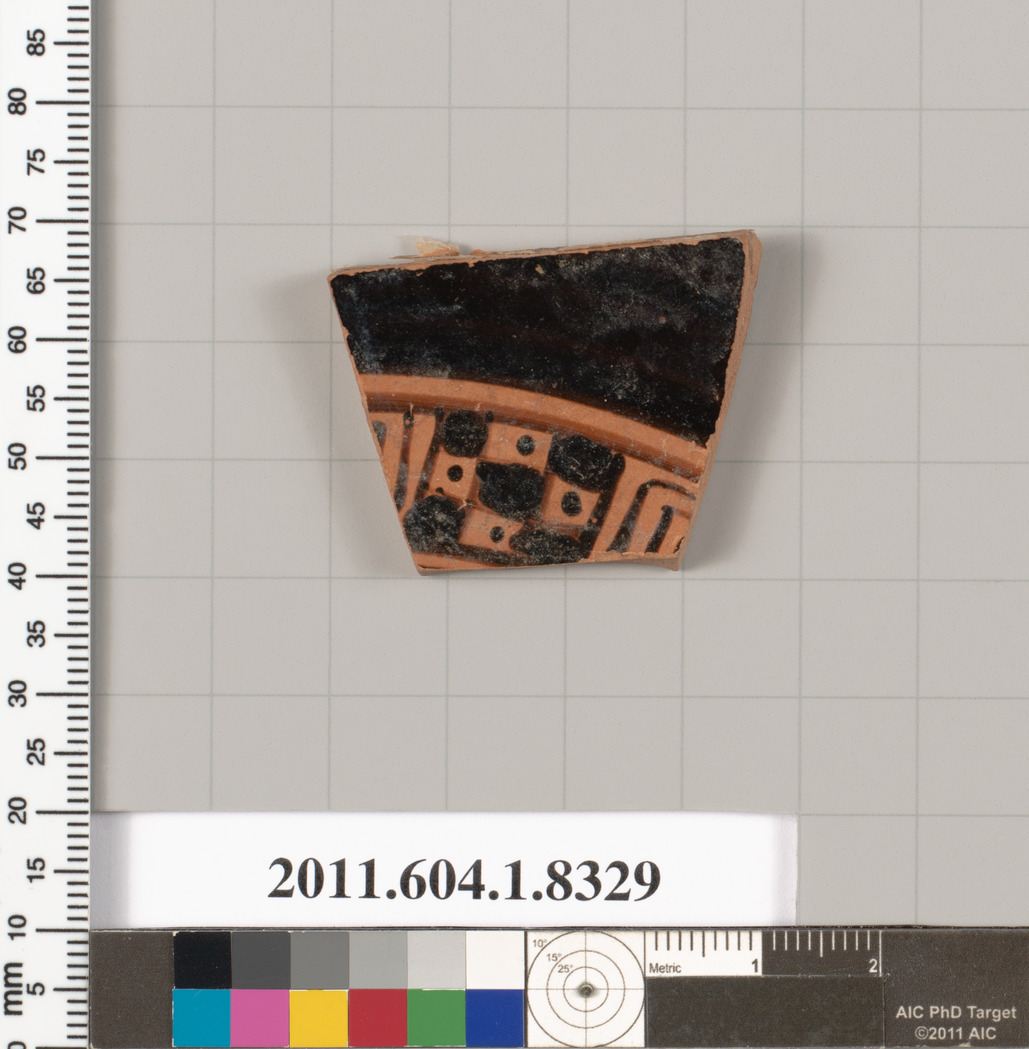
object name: kylix fragment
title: Terracotta fragment of a kylix (drinking cup)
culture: greek, attic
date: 400-376 BCE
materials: terracotta